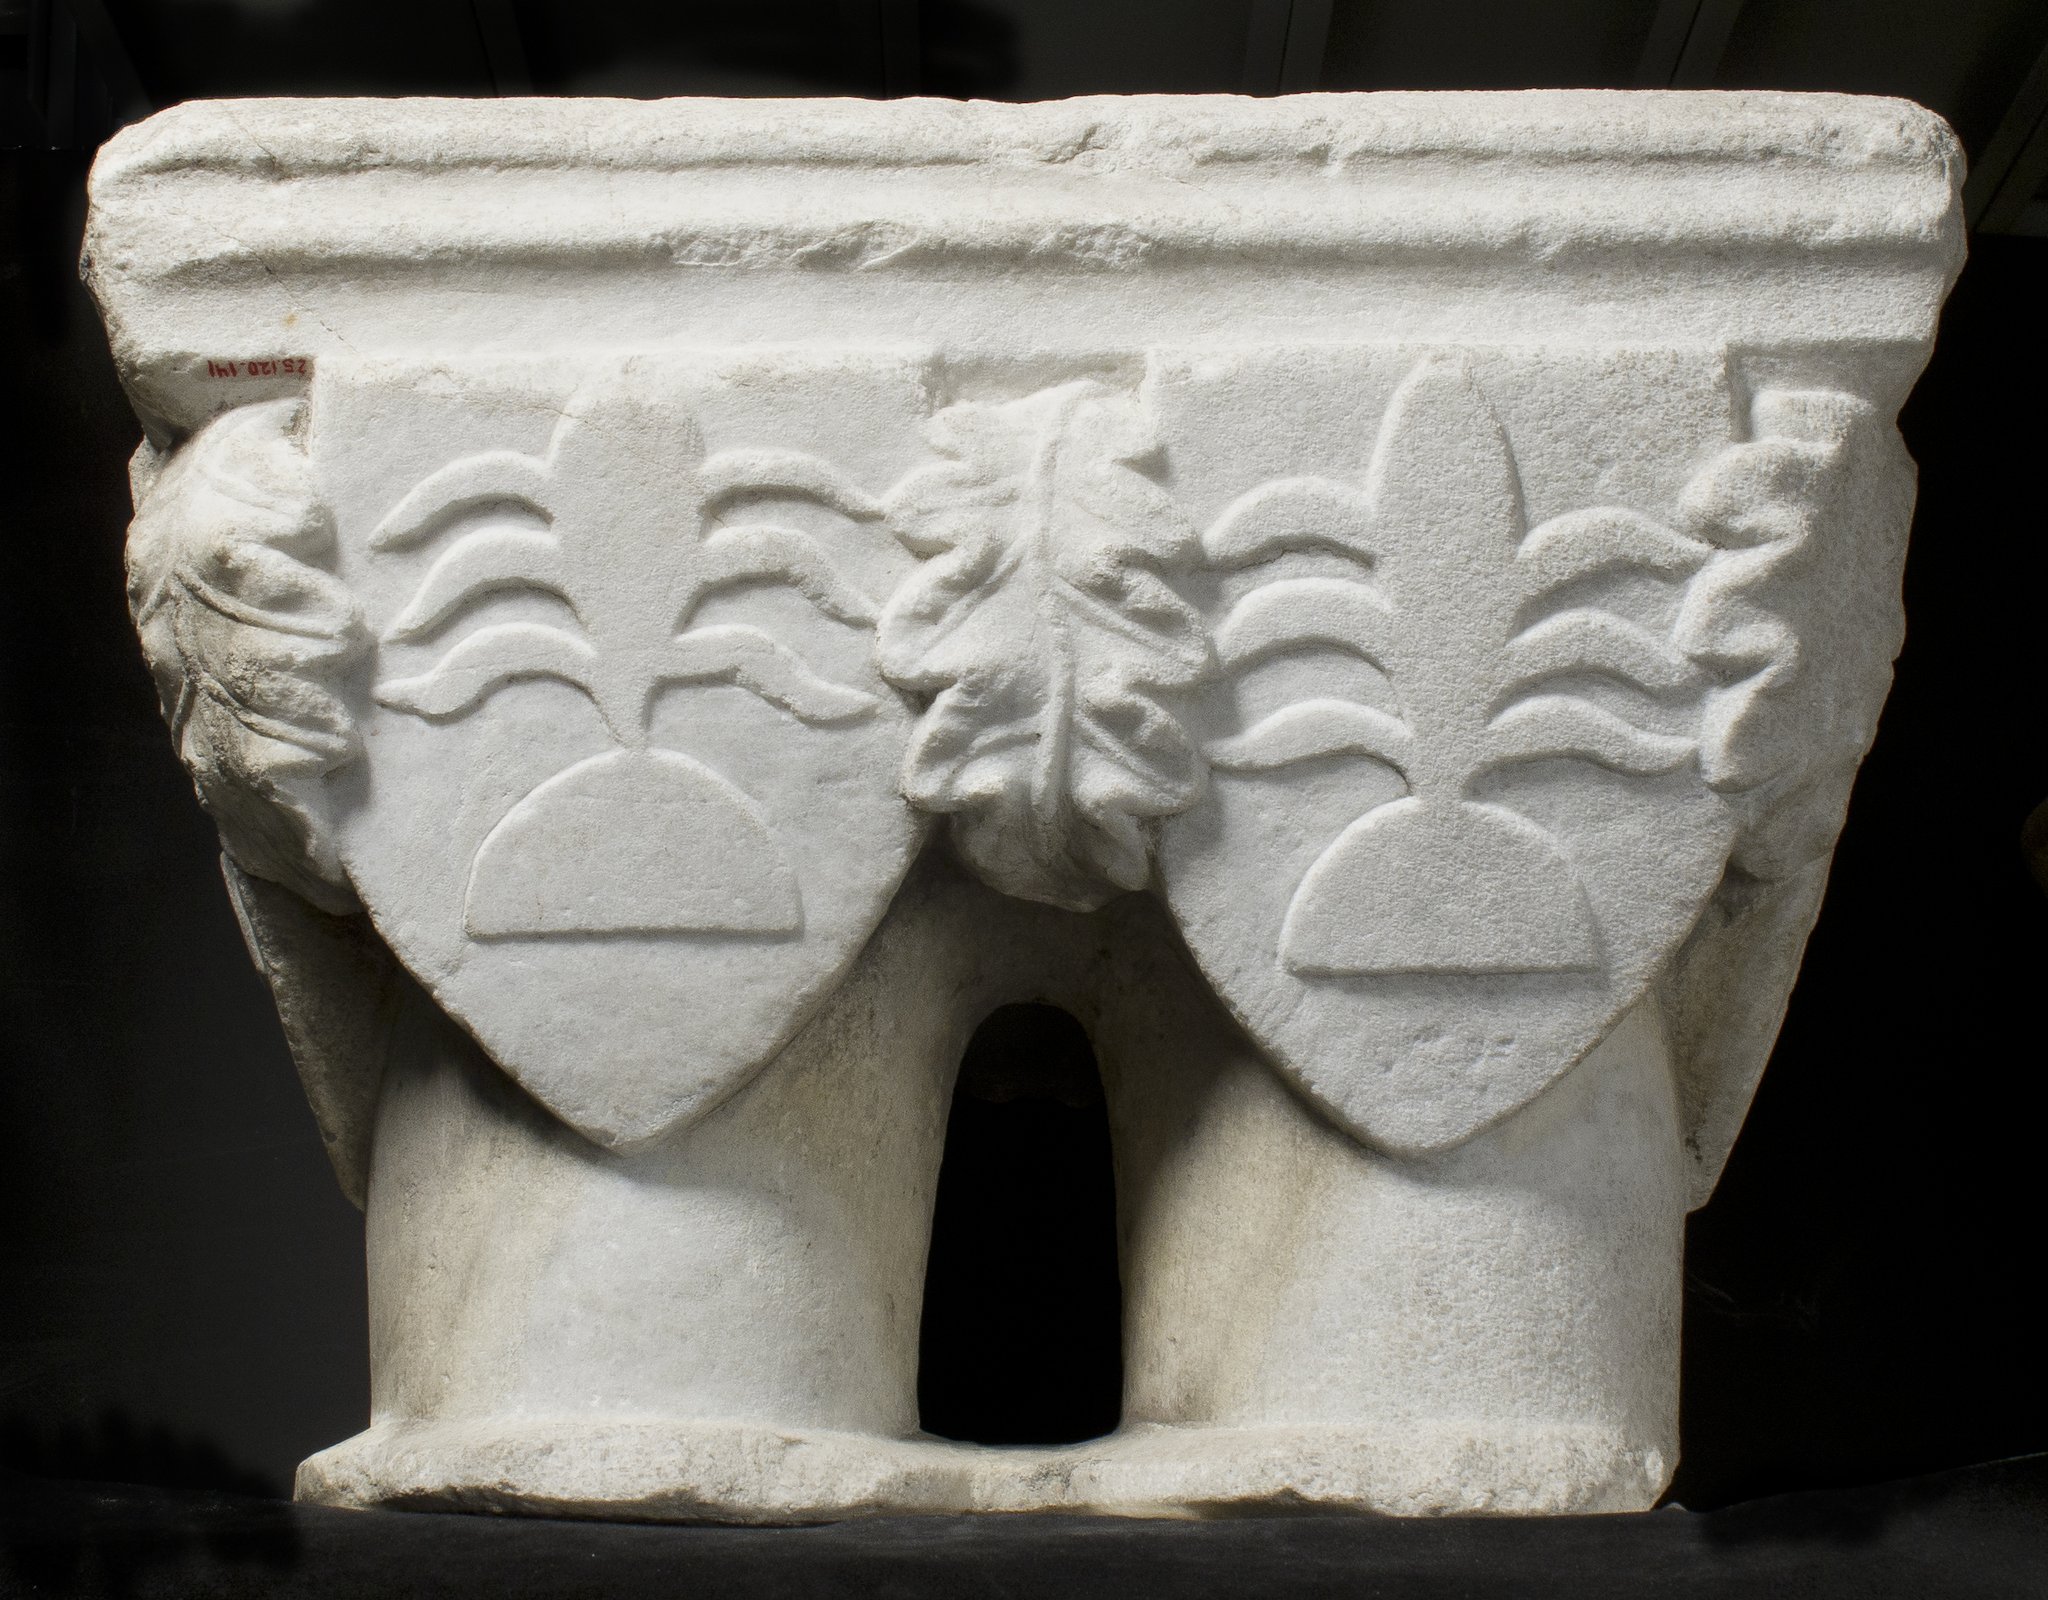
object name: capital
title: Double Capital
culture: french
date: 1450-1500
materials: marble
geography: trie or st. sever de rustan